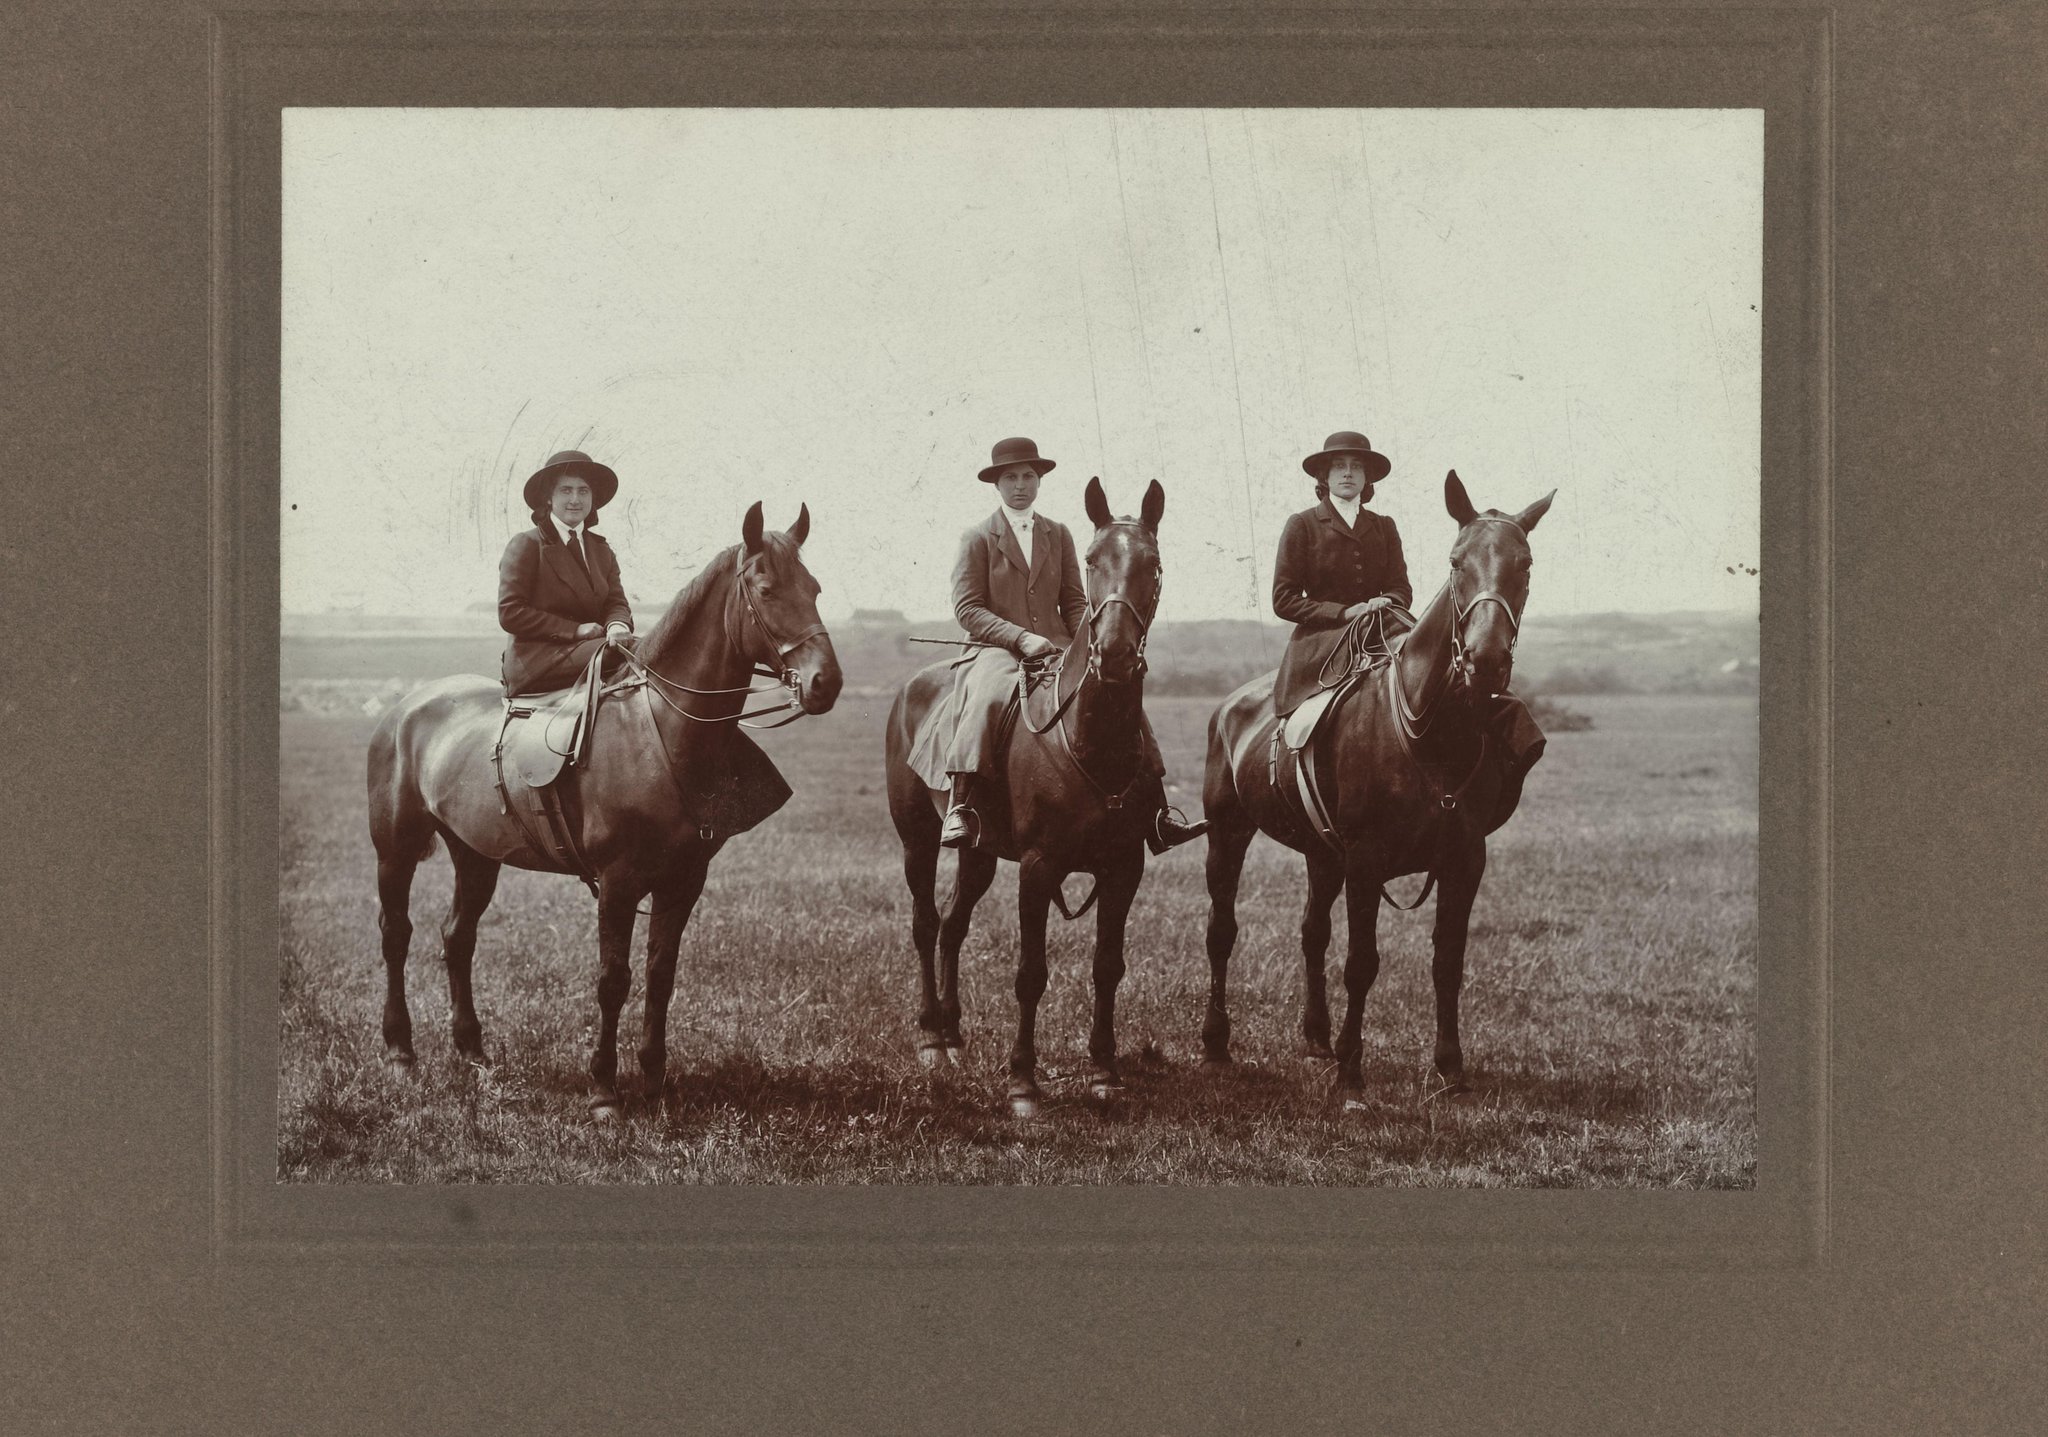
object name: photograph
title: Else Wachenheimer-Moos en twee onbekende vrouwen te paard, Bexhill-on-Sea in Engeland, 1913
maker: Anonymous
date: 1913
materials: photographic support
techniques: gelatin silver print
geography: bexhill-on-sea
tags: else wachenheimer-moos, england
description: Else Wachenheimer-Moos (links) en twee onbekende vrouwen te paard, Bexhill-on-Sea in Engeland.